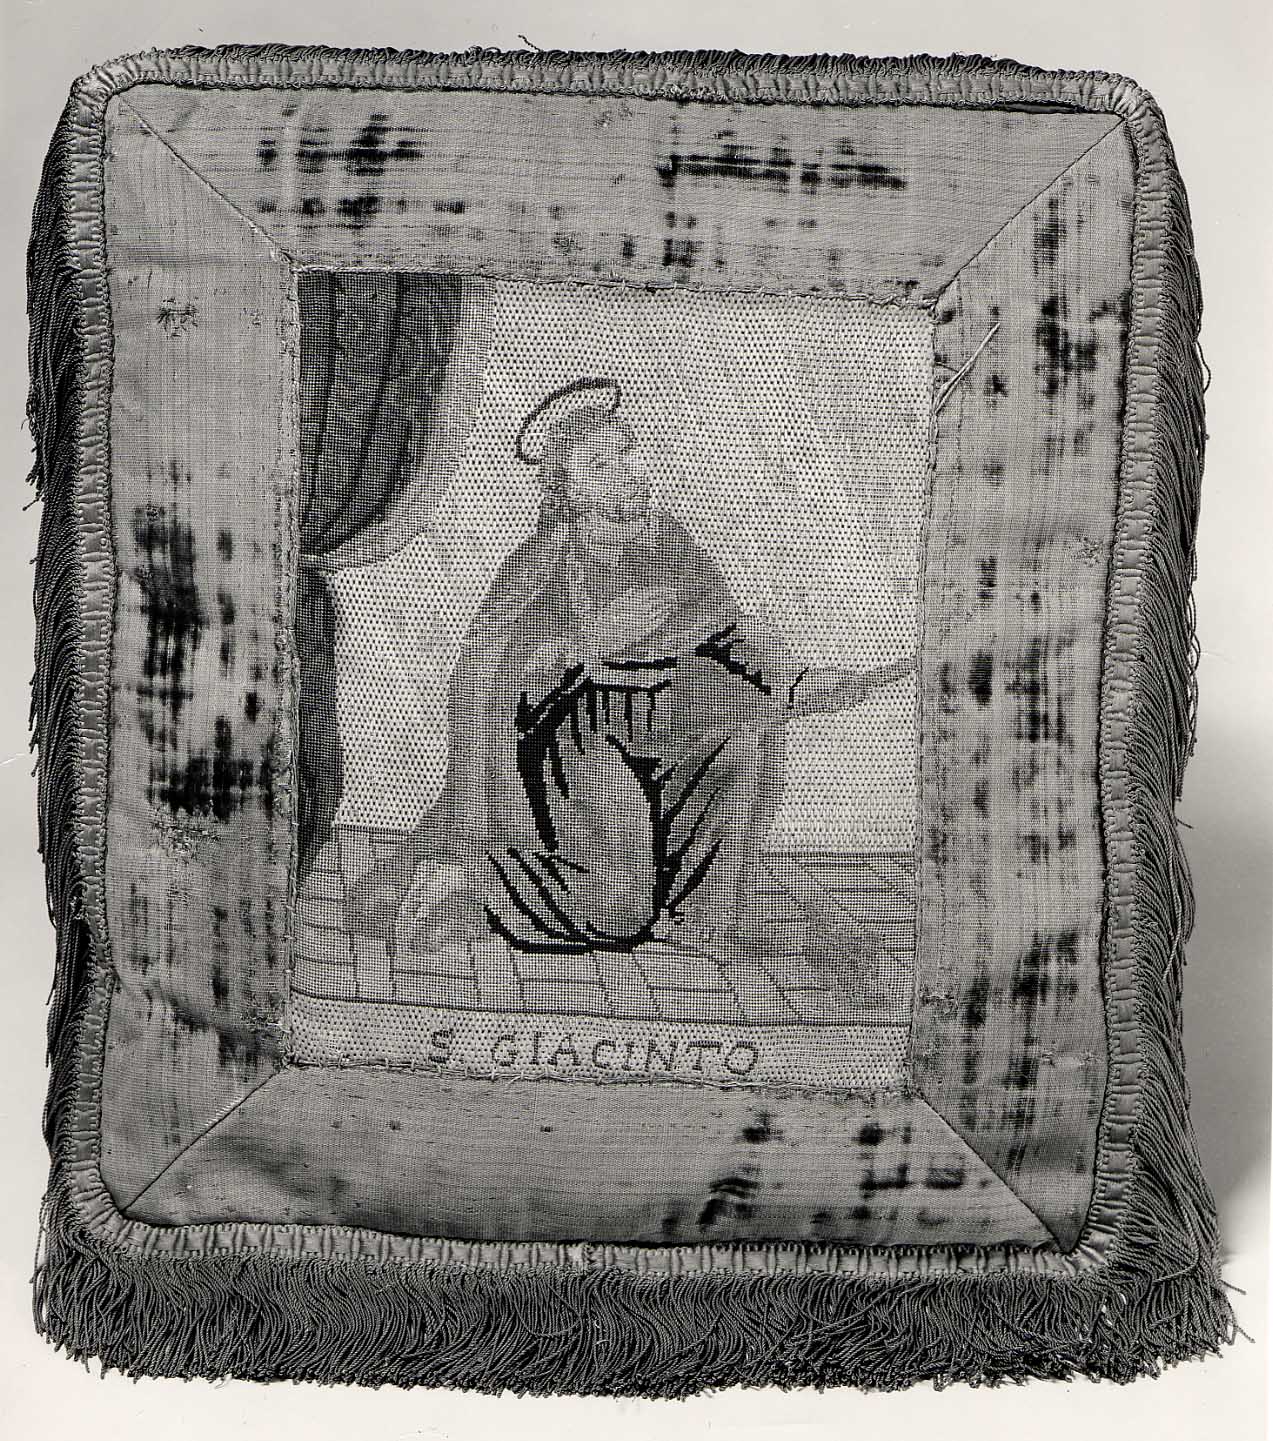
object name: cushion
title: Cushion with Saint Hyacinth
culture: italian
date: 1801-1900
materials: cotton, metal, silk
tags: men,saints